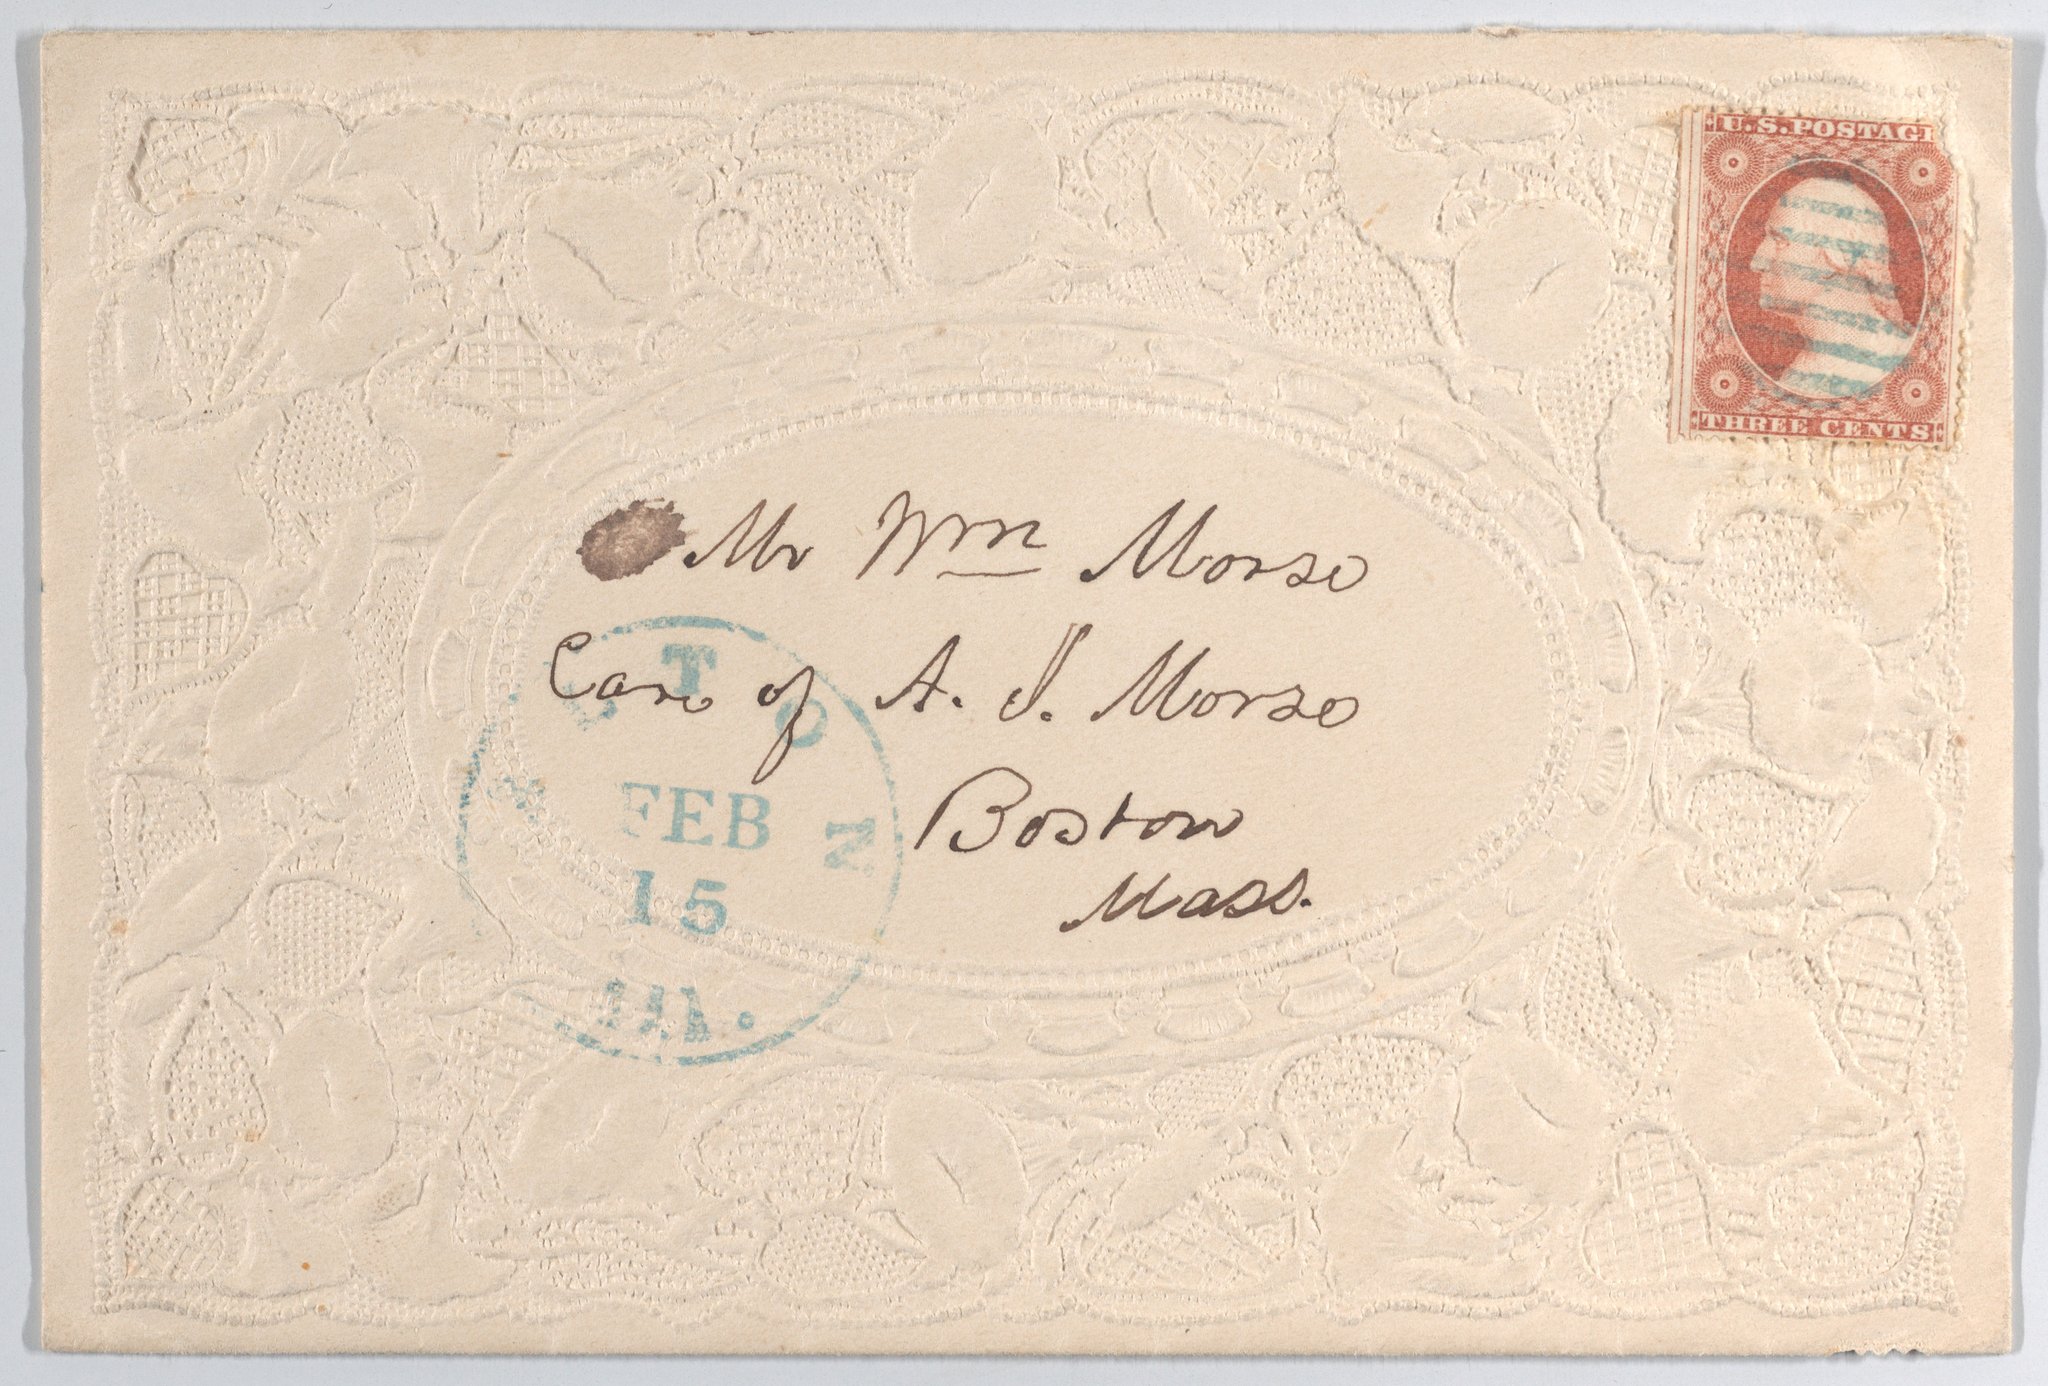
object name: valentine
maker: Anonymous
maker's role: artist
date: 1859-1869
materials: ink, lace, paper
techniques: chromolithography, embossing, open work